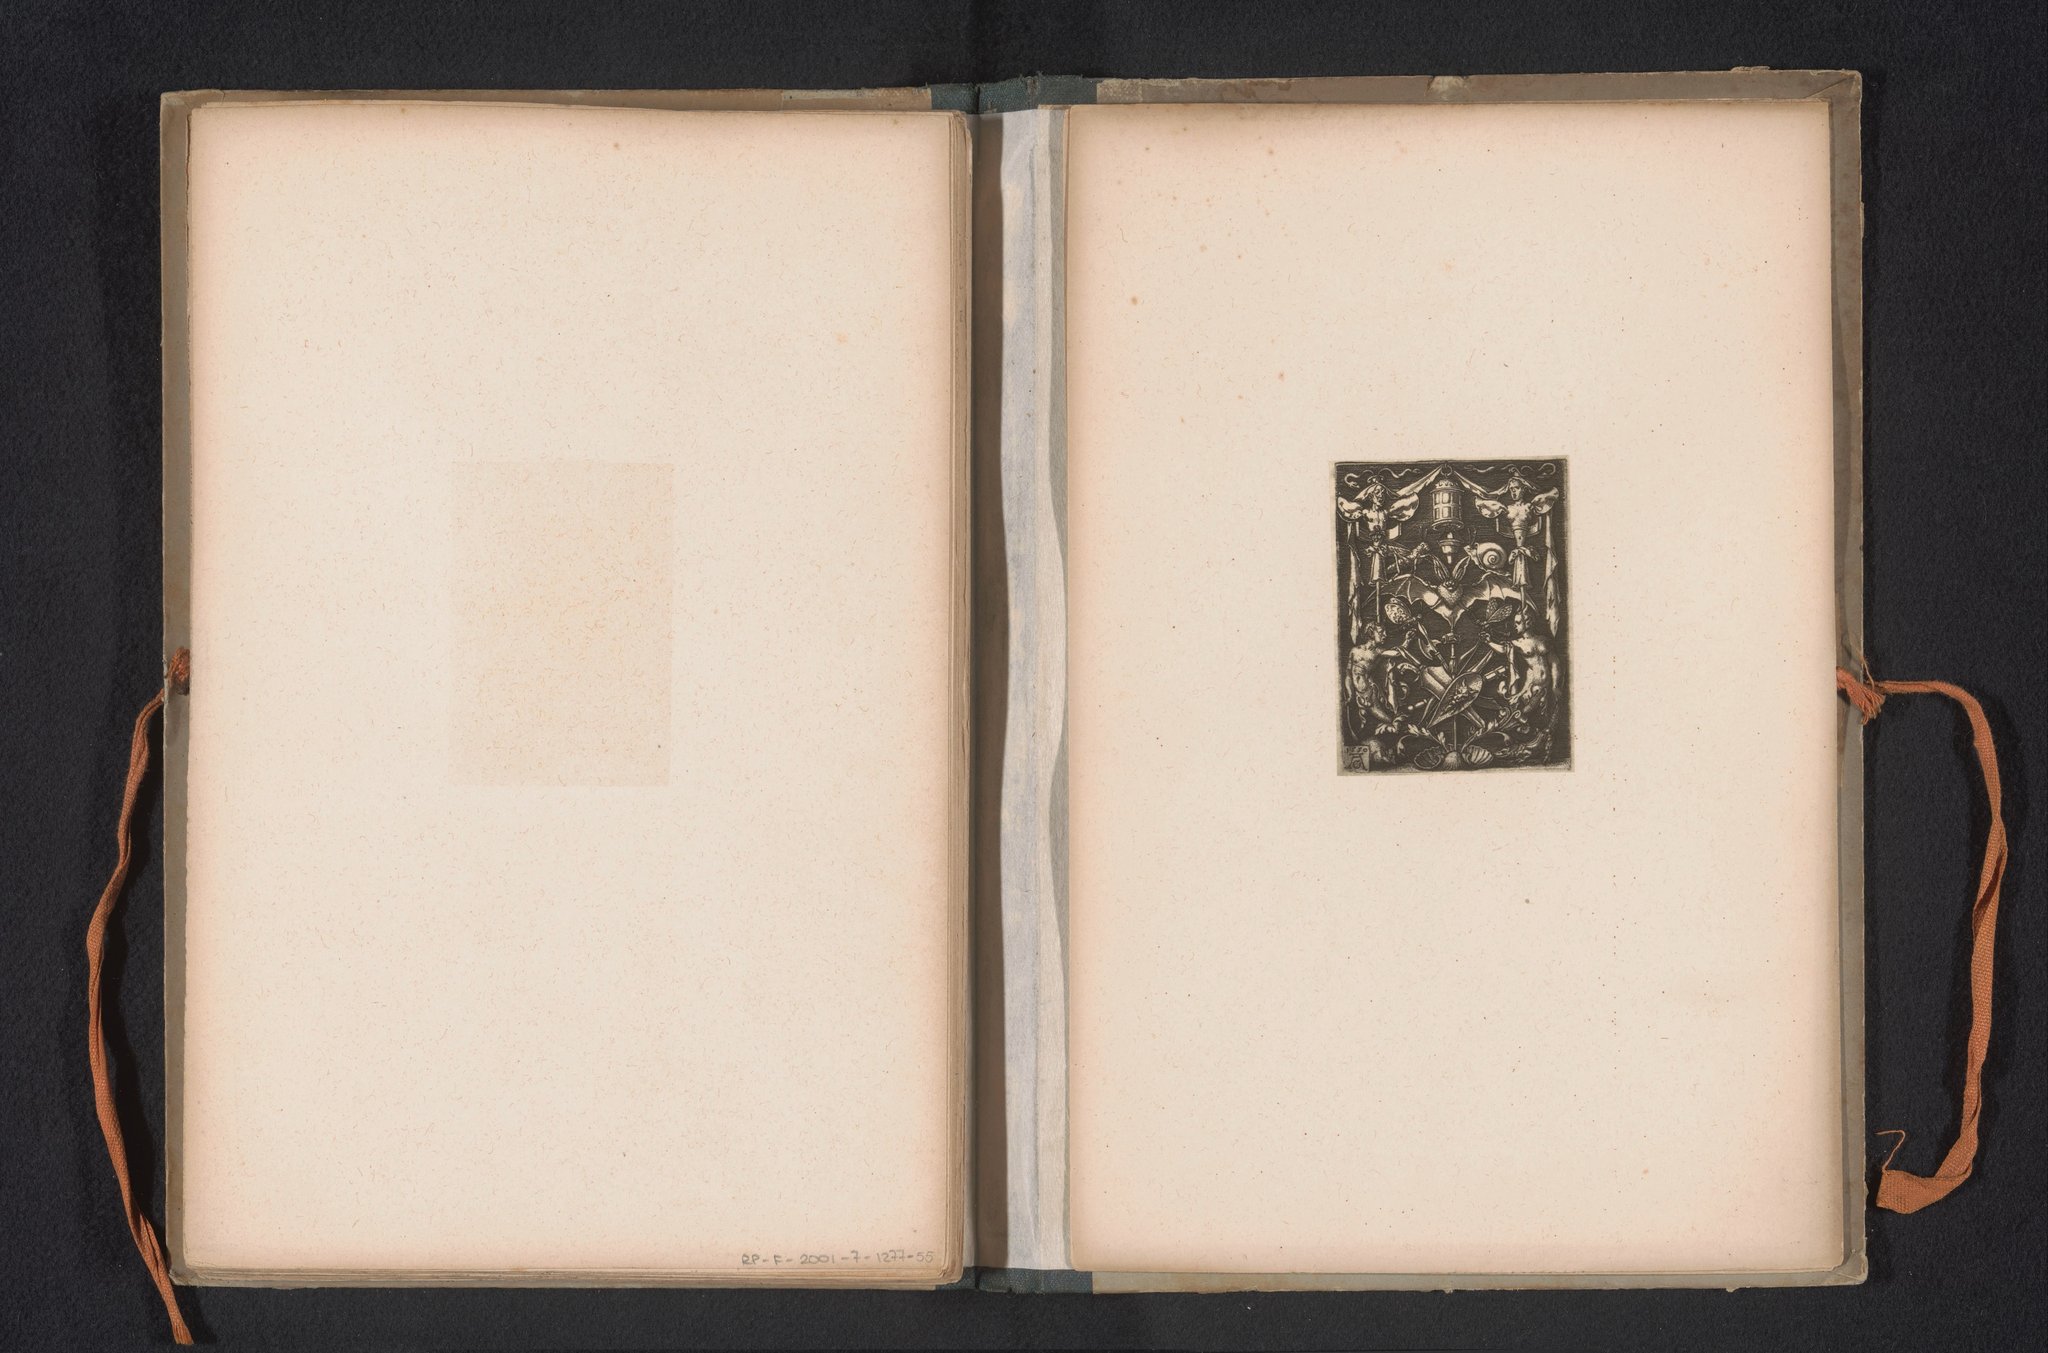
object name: photomechanical print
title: Reproductie van een prent van groteske ornamenten door Heinrich Aldegrever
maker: heinrich aldegrever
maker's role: draughtsman, print maker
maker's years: 1502-1561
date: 1866-1871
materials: paper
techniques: woodburytype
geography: brussels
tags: ornament ~ grotesque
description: Deze prent maakt deel uit van een omslag met 57 prenten op 54 bladen.